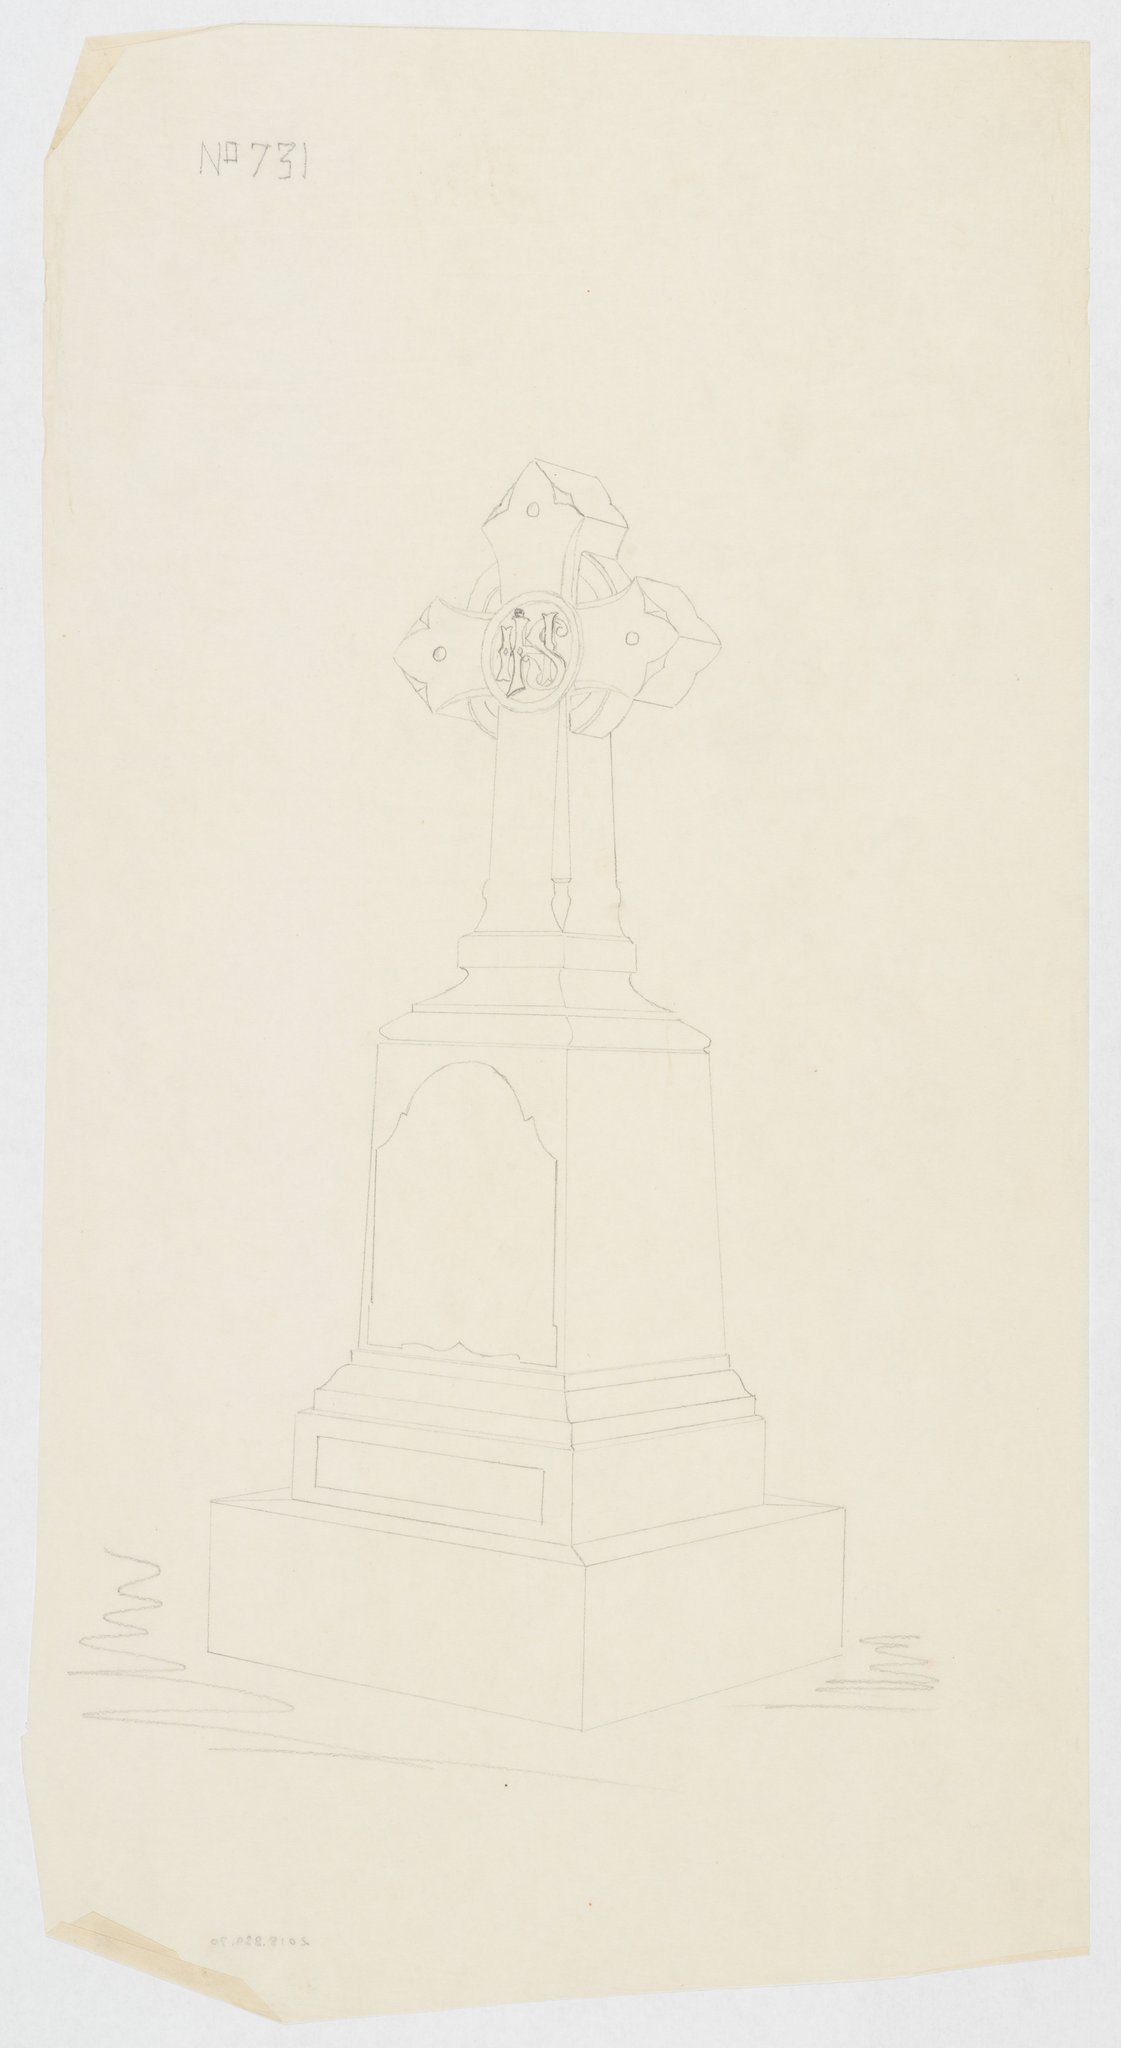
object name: drawing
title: Grave Monument with Cross, No. 731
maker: alexander maxwell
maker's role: artist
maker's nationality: american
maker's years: 1838-1880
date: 1840-1880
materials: graphite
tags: monuments